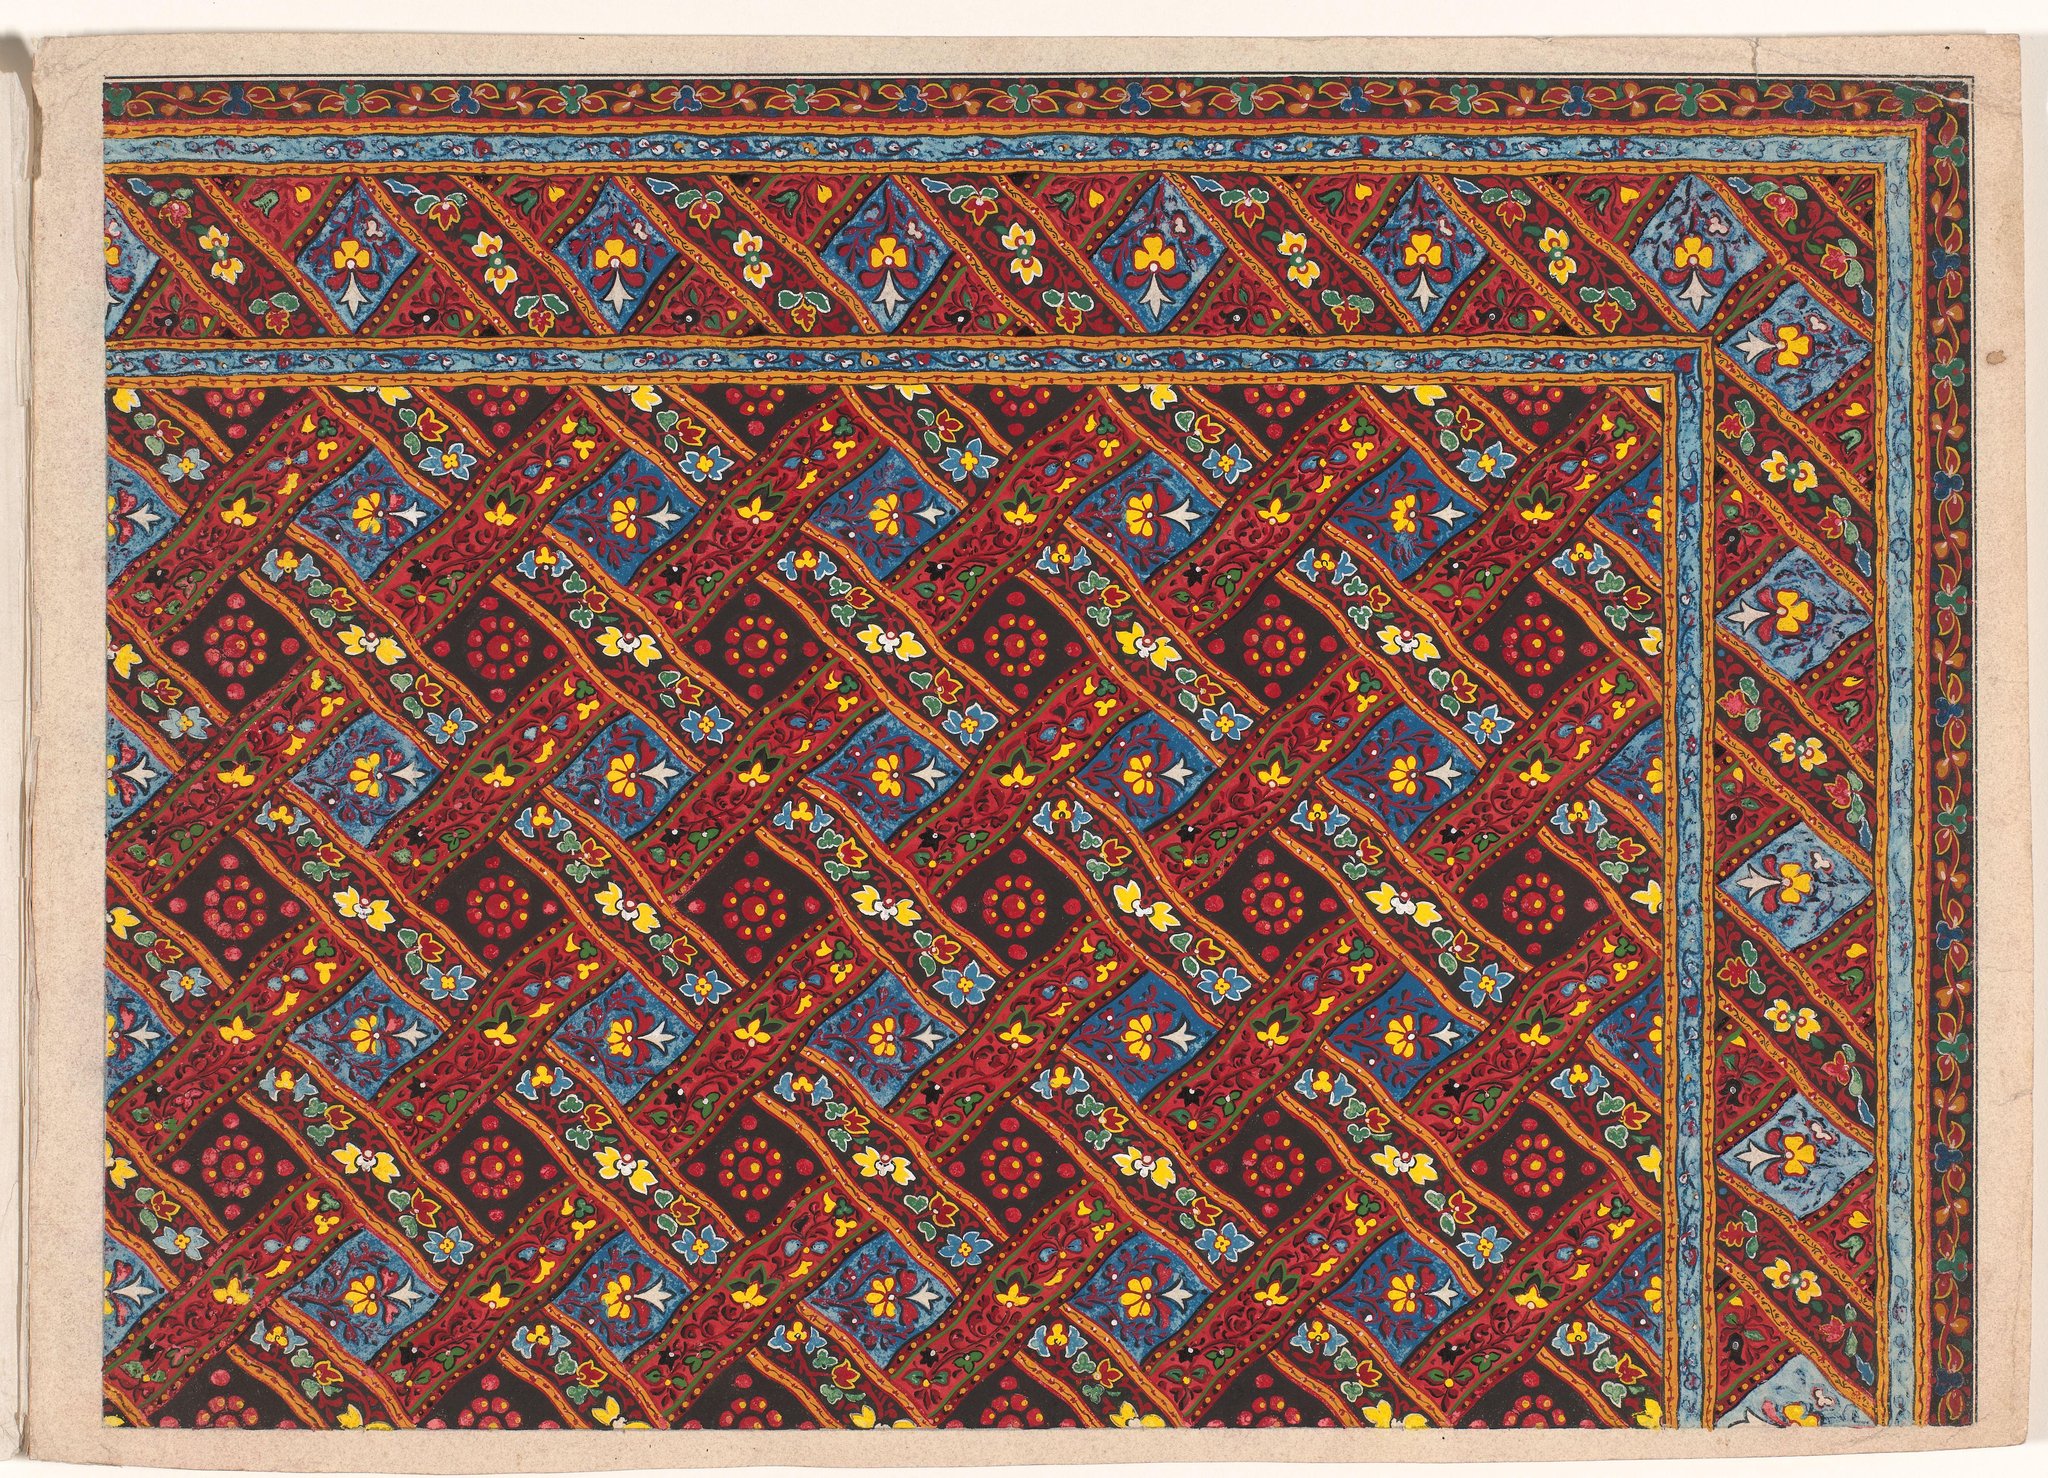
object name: design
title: Ontwerp voor een tapijt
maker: Anonymous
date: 1854-1864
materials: gouache, paper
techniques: brush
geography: deventer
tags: ornaments ~ art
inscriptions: retailer's mark: ‘JHS.’, inscription: ‘i. 3’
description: De presentatietekeningen BK-1971-77-1 t/m 86 zijn kopieën van de originele ontwerptekeningen. Ze werden gemaakt voor vertegenwoordigers van bijvoorbeeld magazijnen, die ze aan hun klanten konden tonen. De meeste tekeningen tonen een kwart van het dessin inclusief rand, middenpartij (de zogenaamde grond of fond) en centraal medaillon. Door het gebruik van spiegels kan de illusie van het gehele tapijt worden opgeroepen. Een deel van de tekeningen heeft een alfabetische opeenvolgende letter als kenmerk, de andere groep een cijfer.Waarschijnlijk is de reeks dessins met een letter eerder samengesteld dan de genummerde tekeningen.